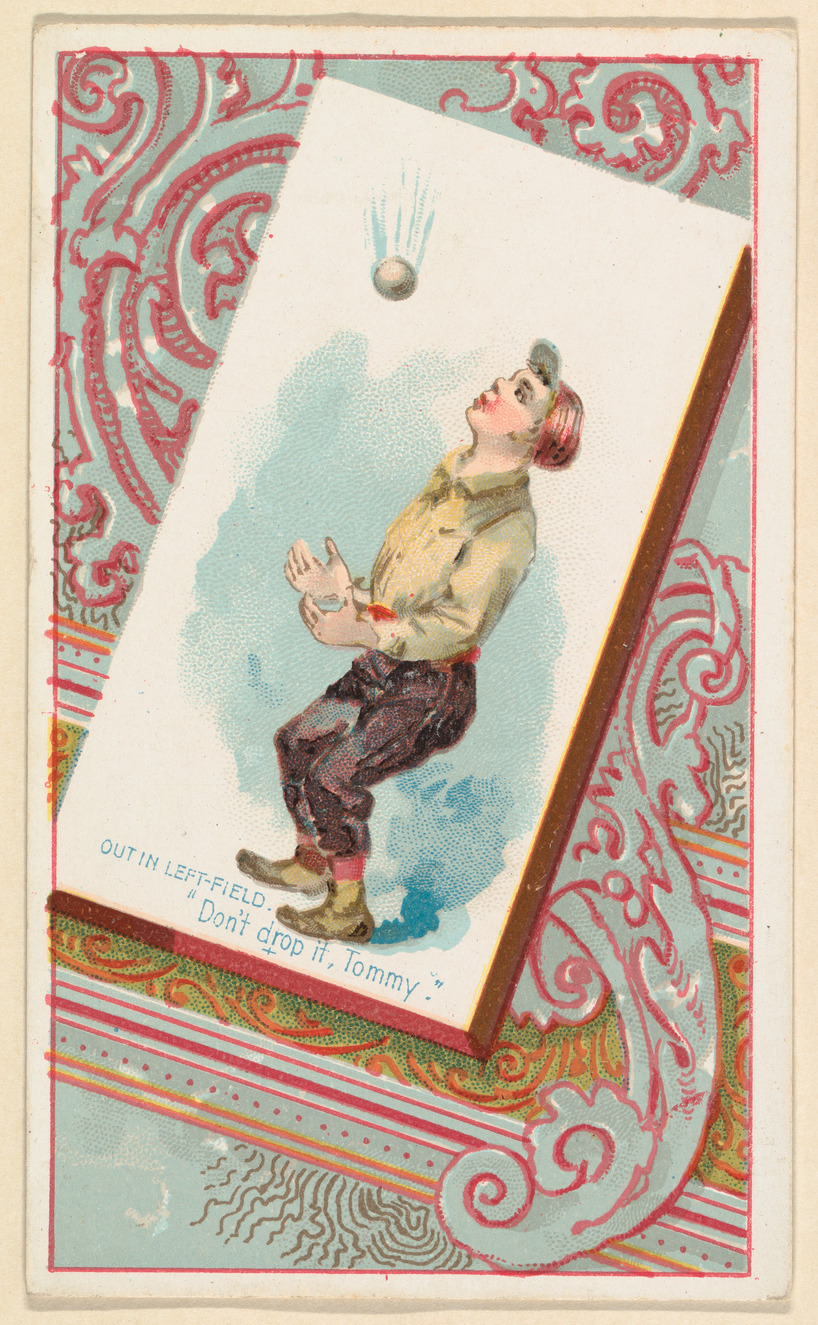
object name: print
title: Out in left-field, "Don't drop it, Tommy," from the Terrors of America set (N136) issued by Duke Sons & Co. to promote Honest Long Cut Tobacco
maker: w. duke, sons & co.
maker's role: publisher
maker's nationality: american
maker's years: 1870-1920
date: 1888-1889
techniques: color lithograph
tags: boys,playing